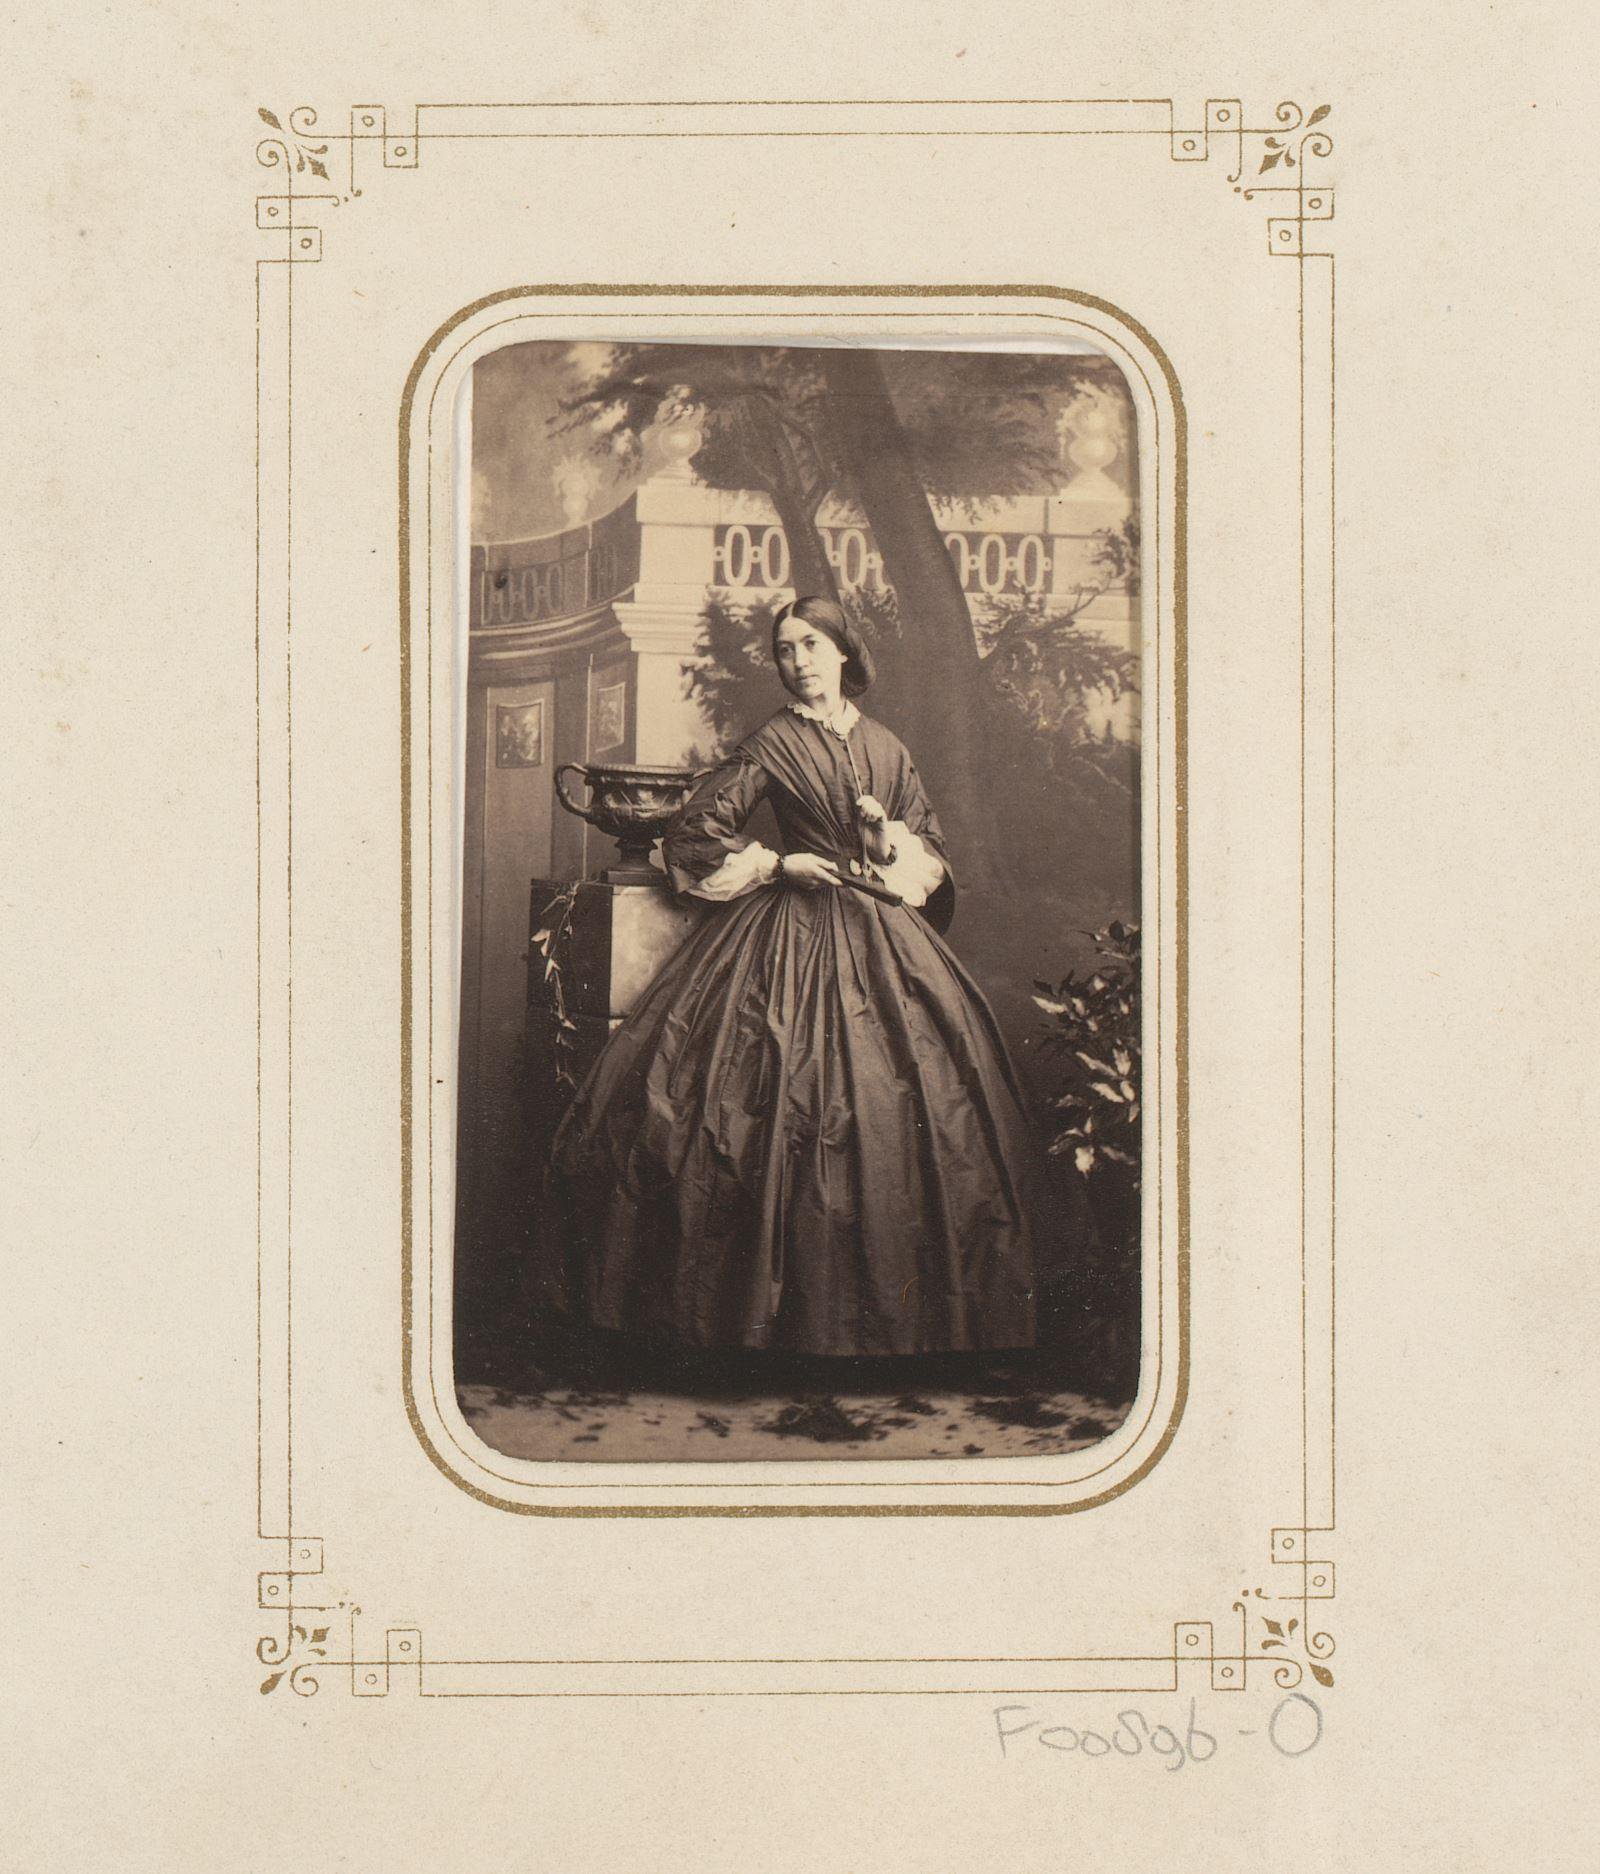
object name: carte de visite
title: Portret van een vrouw met een waaier in de hand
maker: camille leon louis silvy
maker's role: fotograaf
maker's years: 1834-1910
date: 1861-1869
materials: cardboard, photographic support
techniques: albumen print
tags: standing figure, historical persons, fan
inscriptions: inscription: ‘Photographed by/ C. Silvy/ 38 Porchester Terrace/ Bayswater. W.’